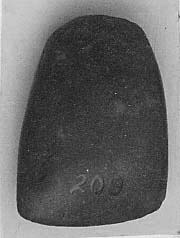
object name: hatchet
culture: french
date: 1902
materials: jade